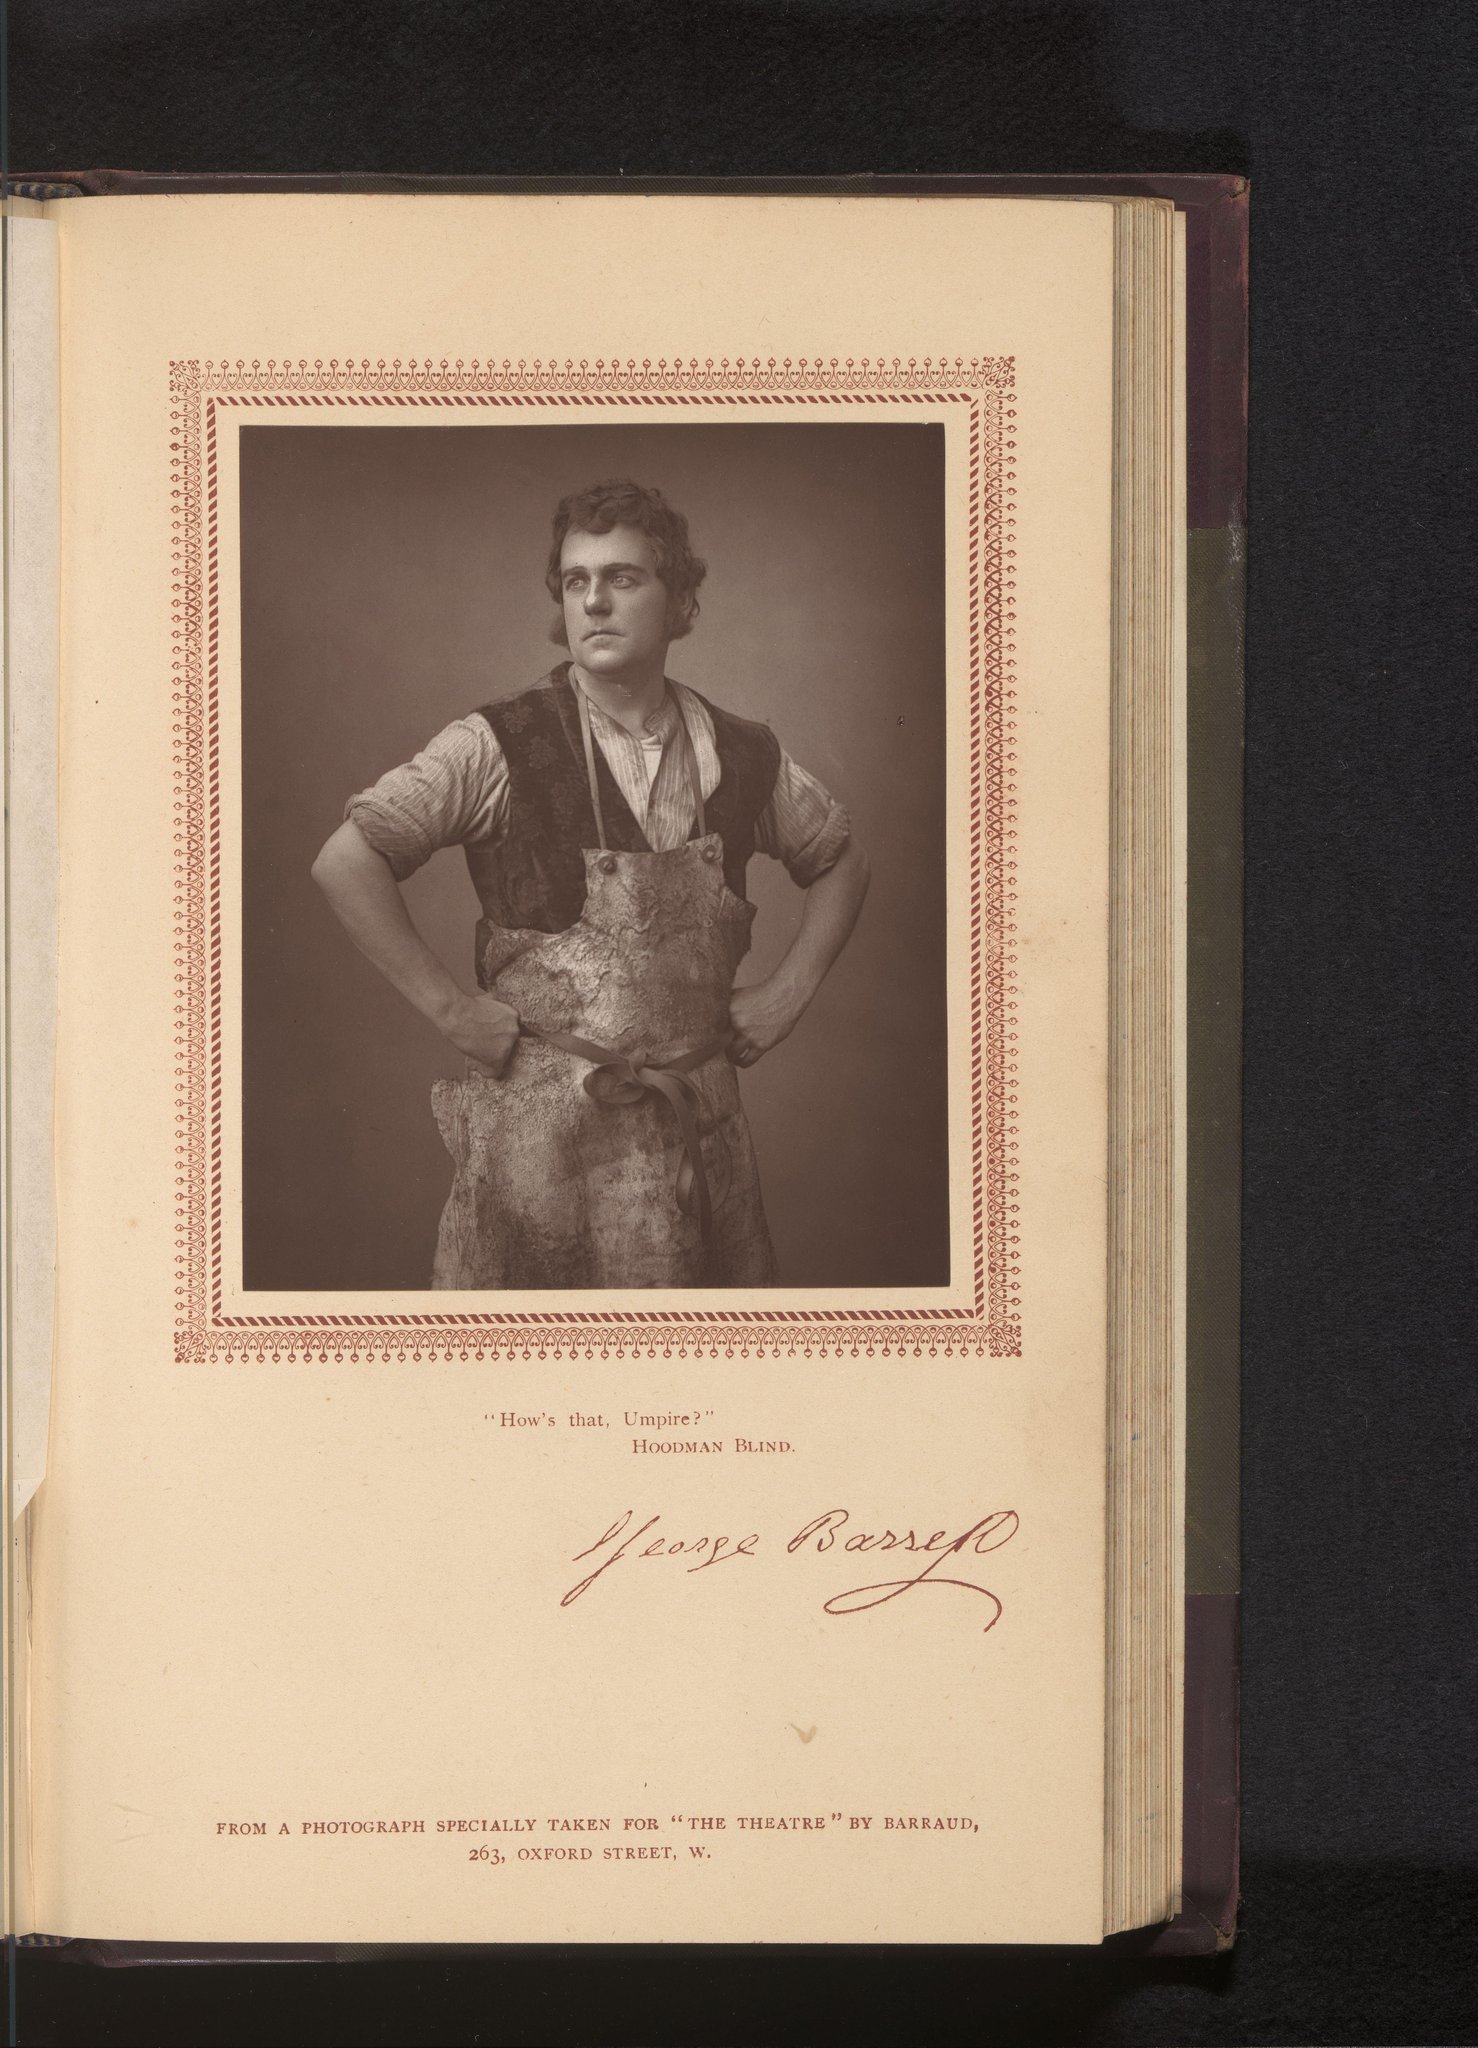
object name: photomechanical print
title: Portret van George Barrett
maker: herbert rose barraud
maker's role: fotograaf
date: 1880-1885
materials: paper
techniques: woodburytype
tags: adult woman, historical persons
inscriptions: signature: ‘George Barrett’, inscription: ‘'How's that Umpire?'/ Hoodman Blind’